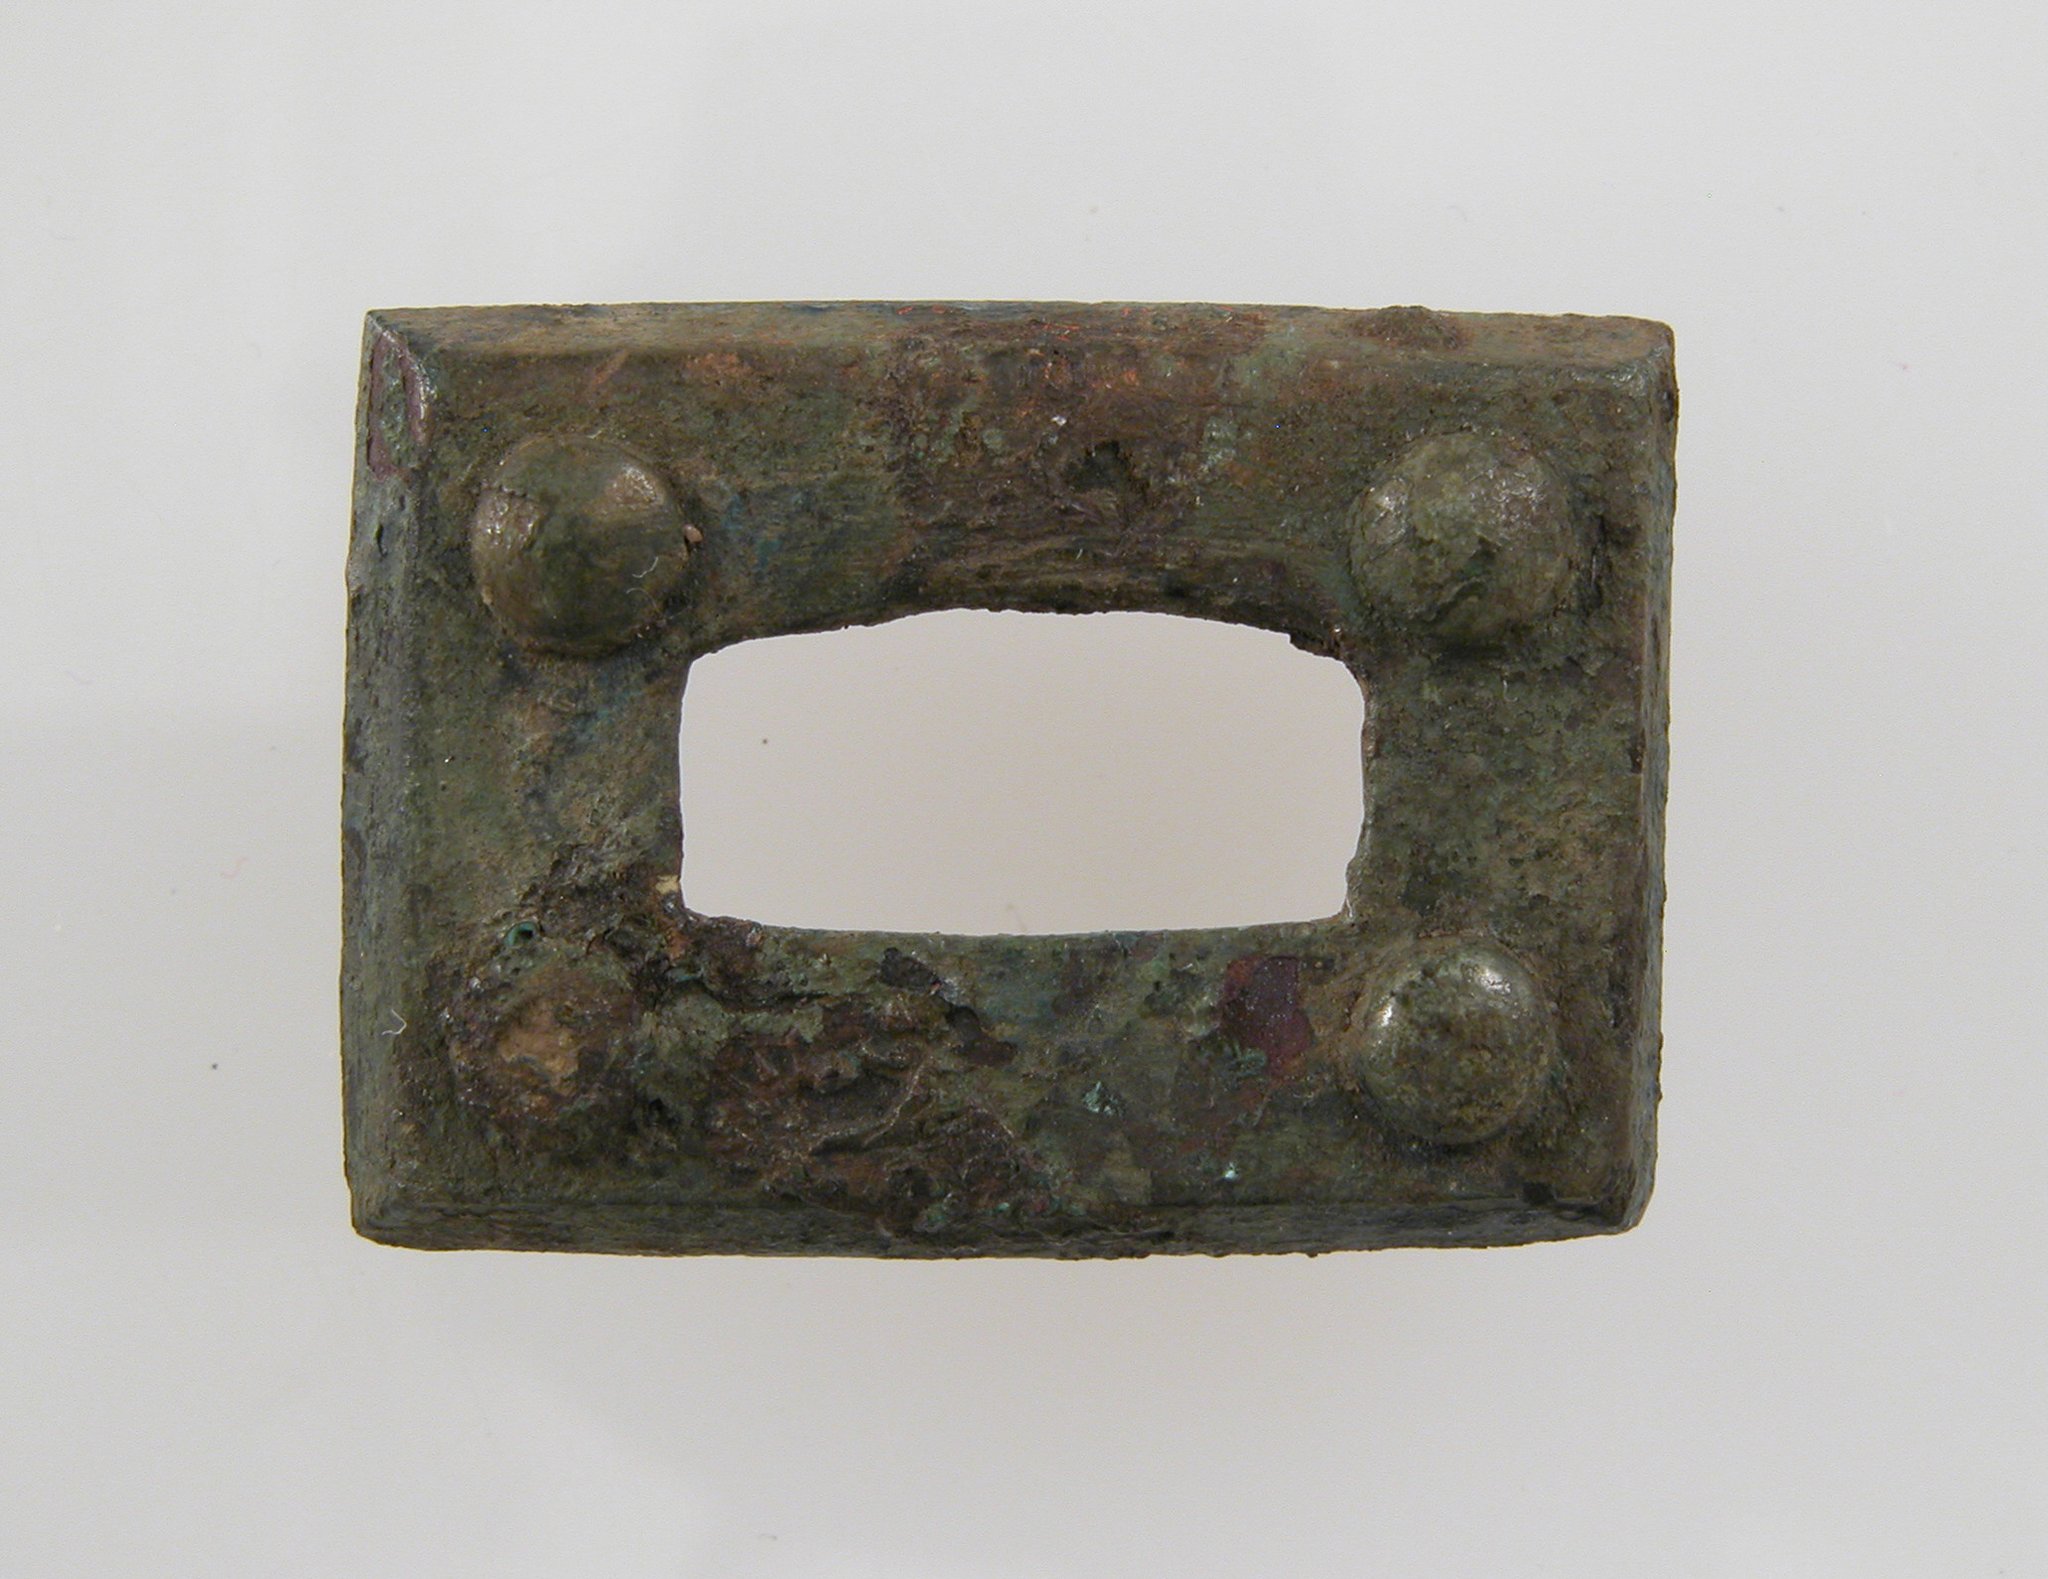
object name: plaque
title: Rectangular Plaque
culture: frankish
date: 500-700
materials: copper alloy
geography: germany